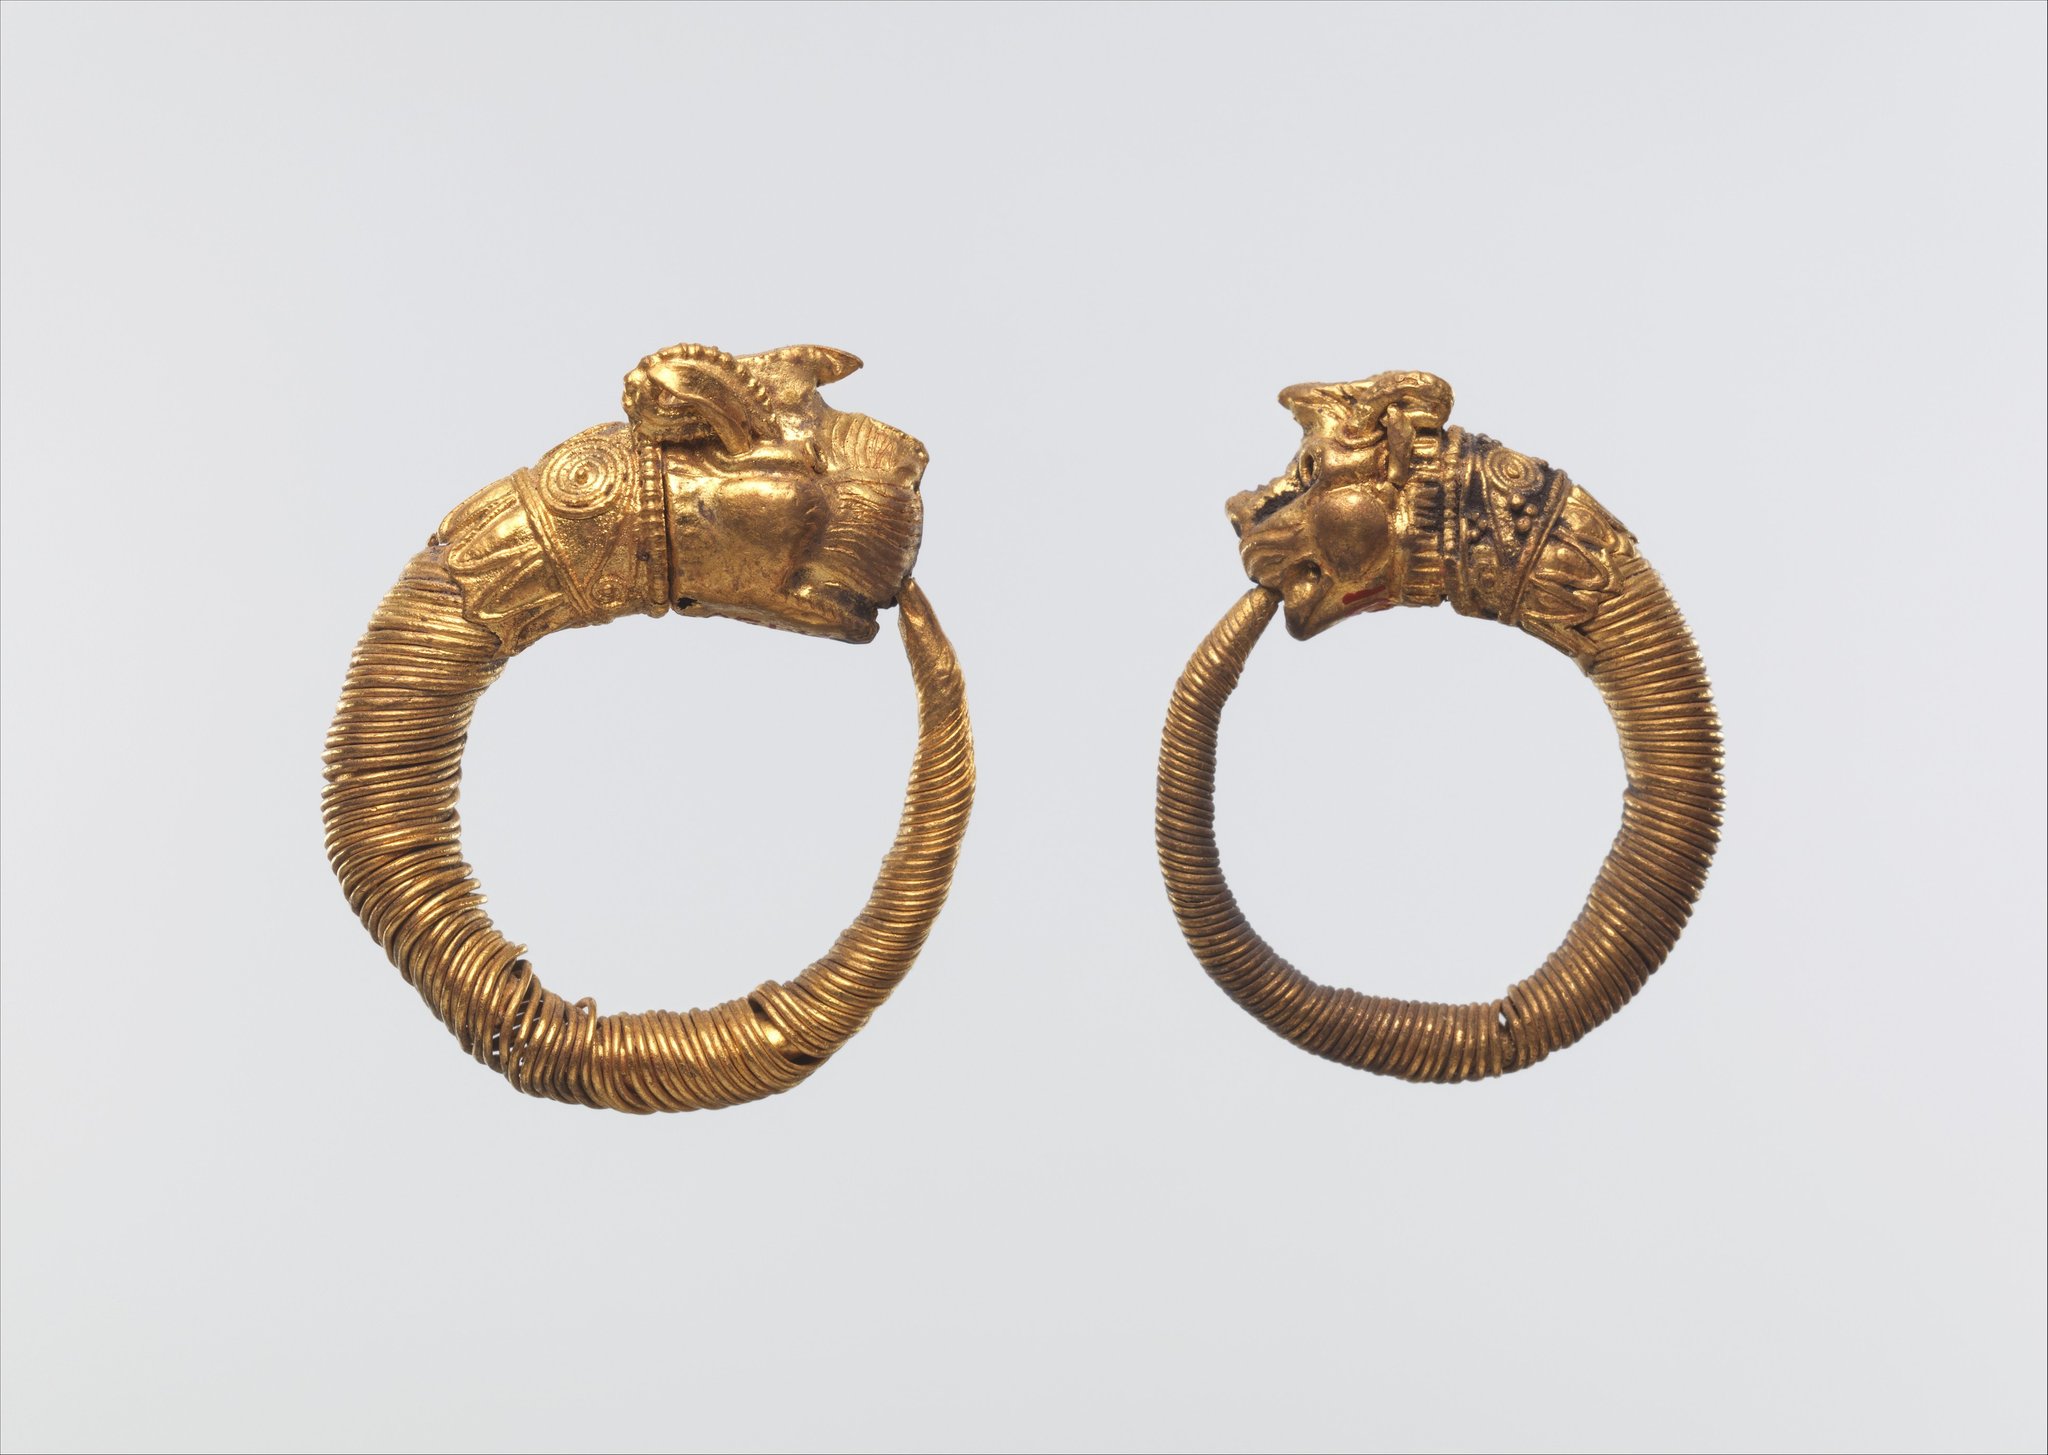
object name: earring, lion griffin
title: Earring with lion-griffin head terminal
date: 400-201 BCE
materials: gold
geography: egypt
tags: griffins